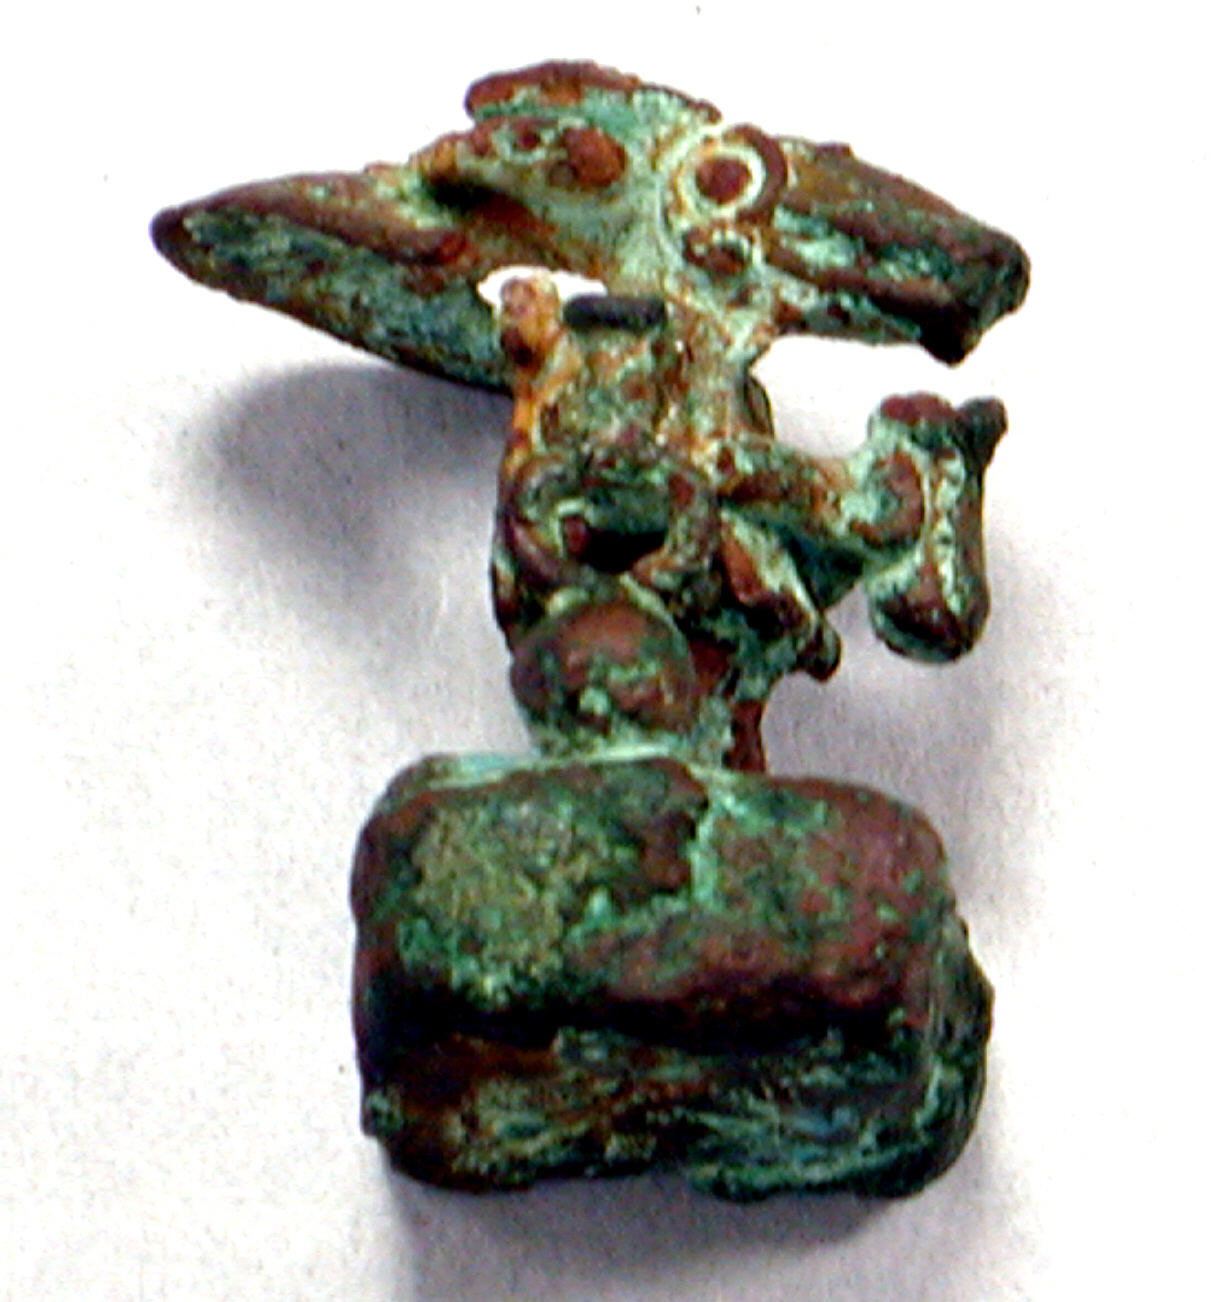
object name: figure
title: Copper Llama (?)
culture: chimú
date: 1101-1500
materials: copper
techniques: casting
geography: peru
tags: animals